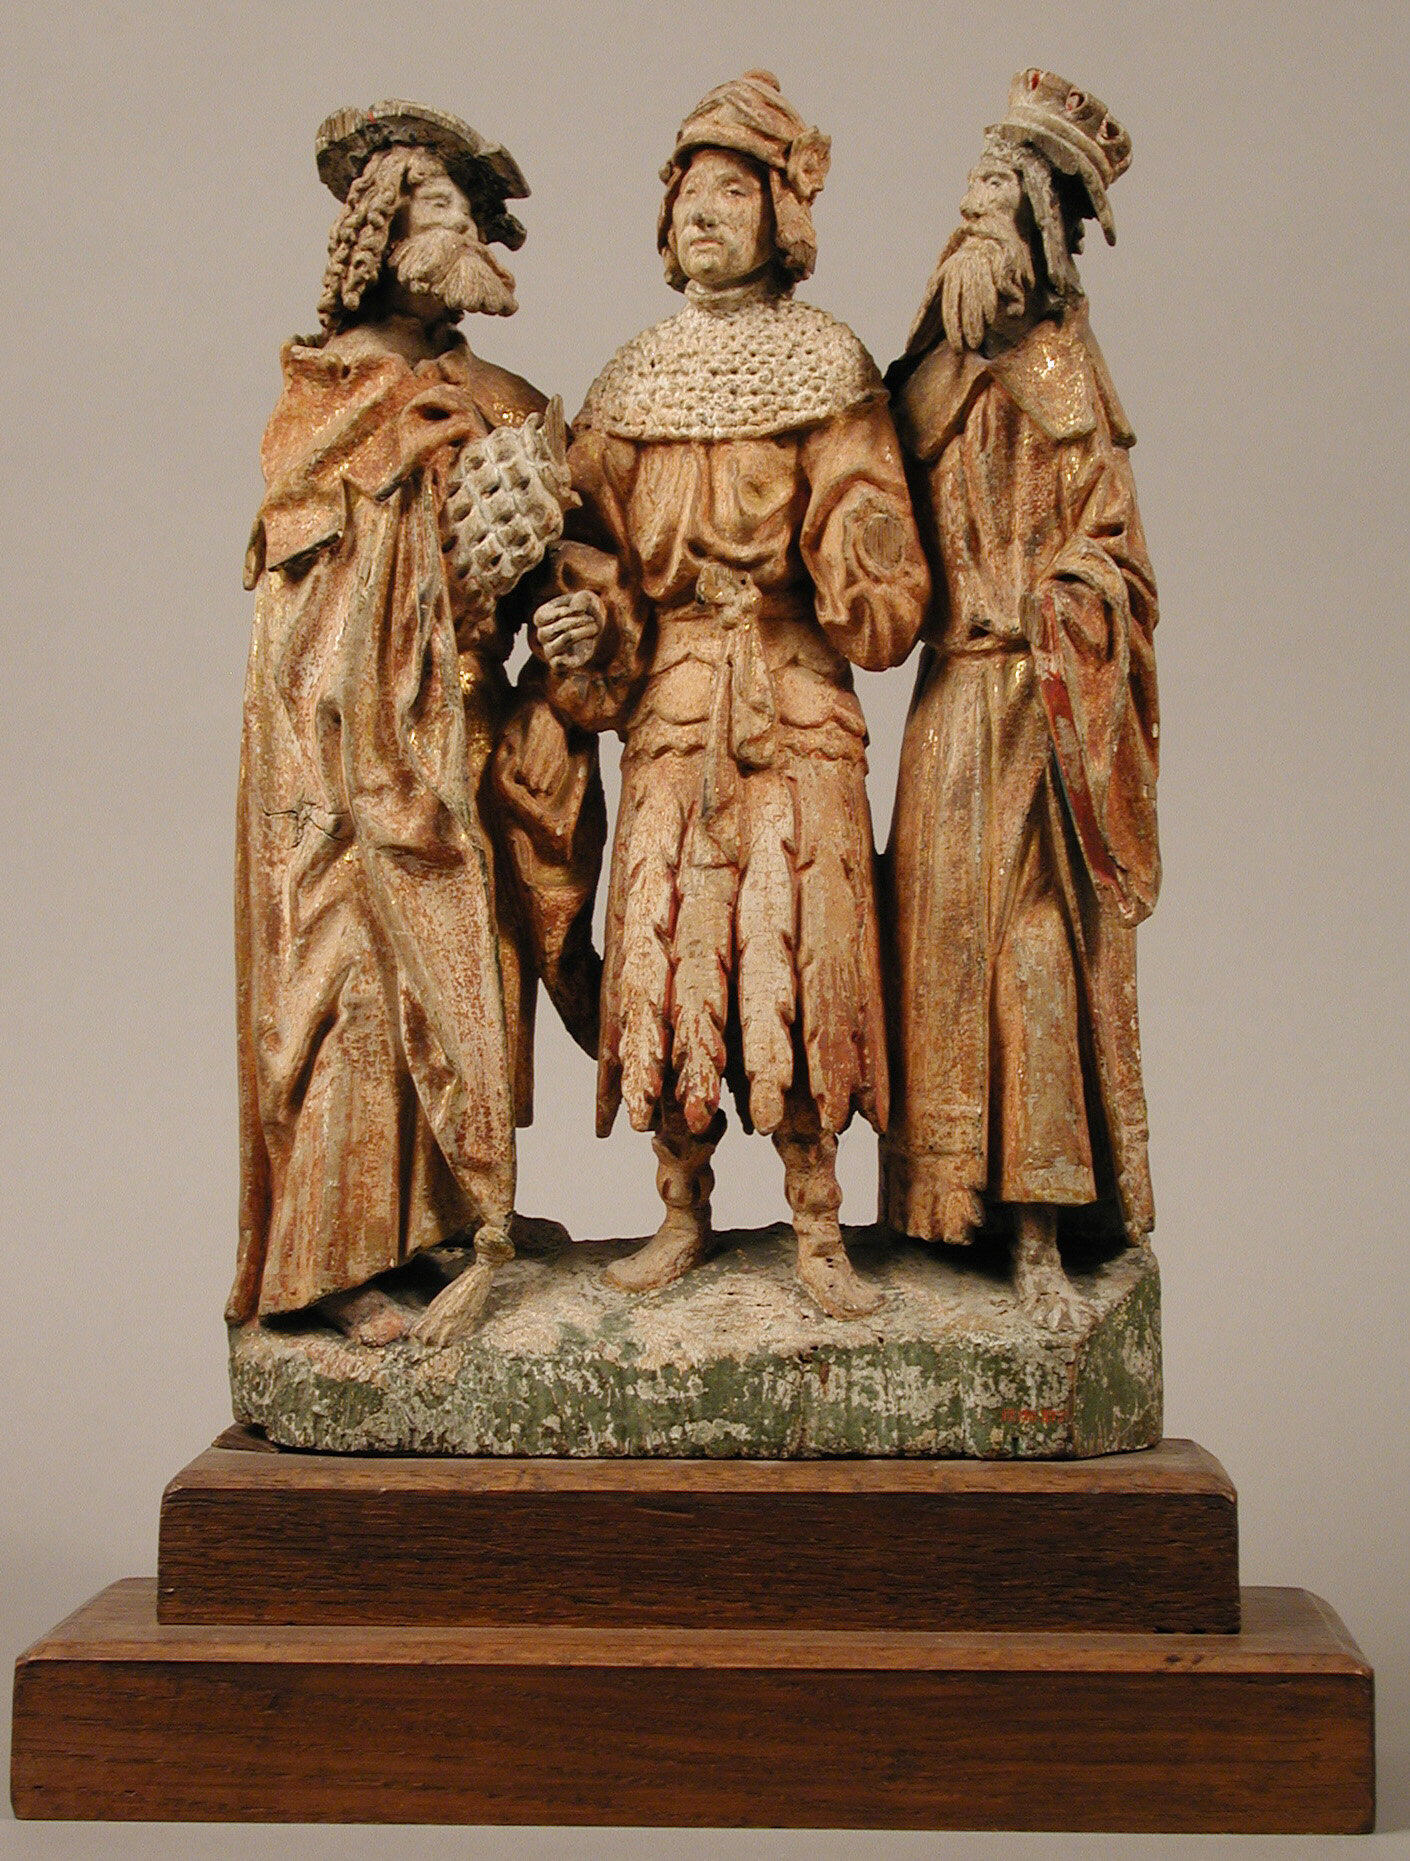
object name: wall group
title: The Three Magi (?)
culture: french or south netherlandish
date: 1401-1500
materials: paint, wood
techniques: gilding